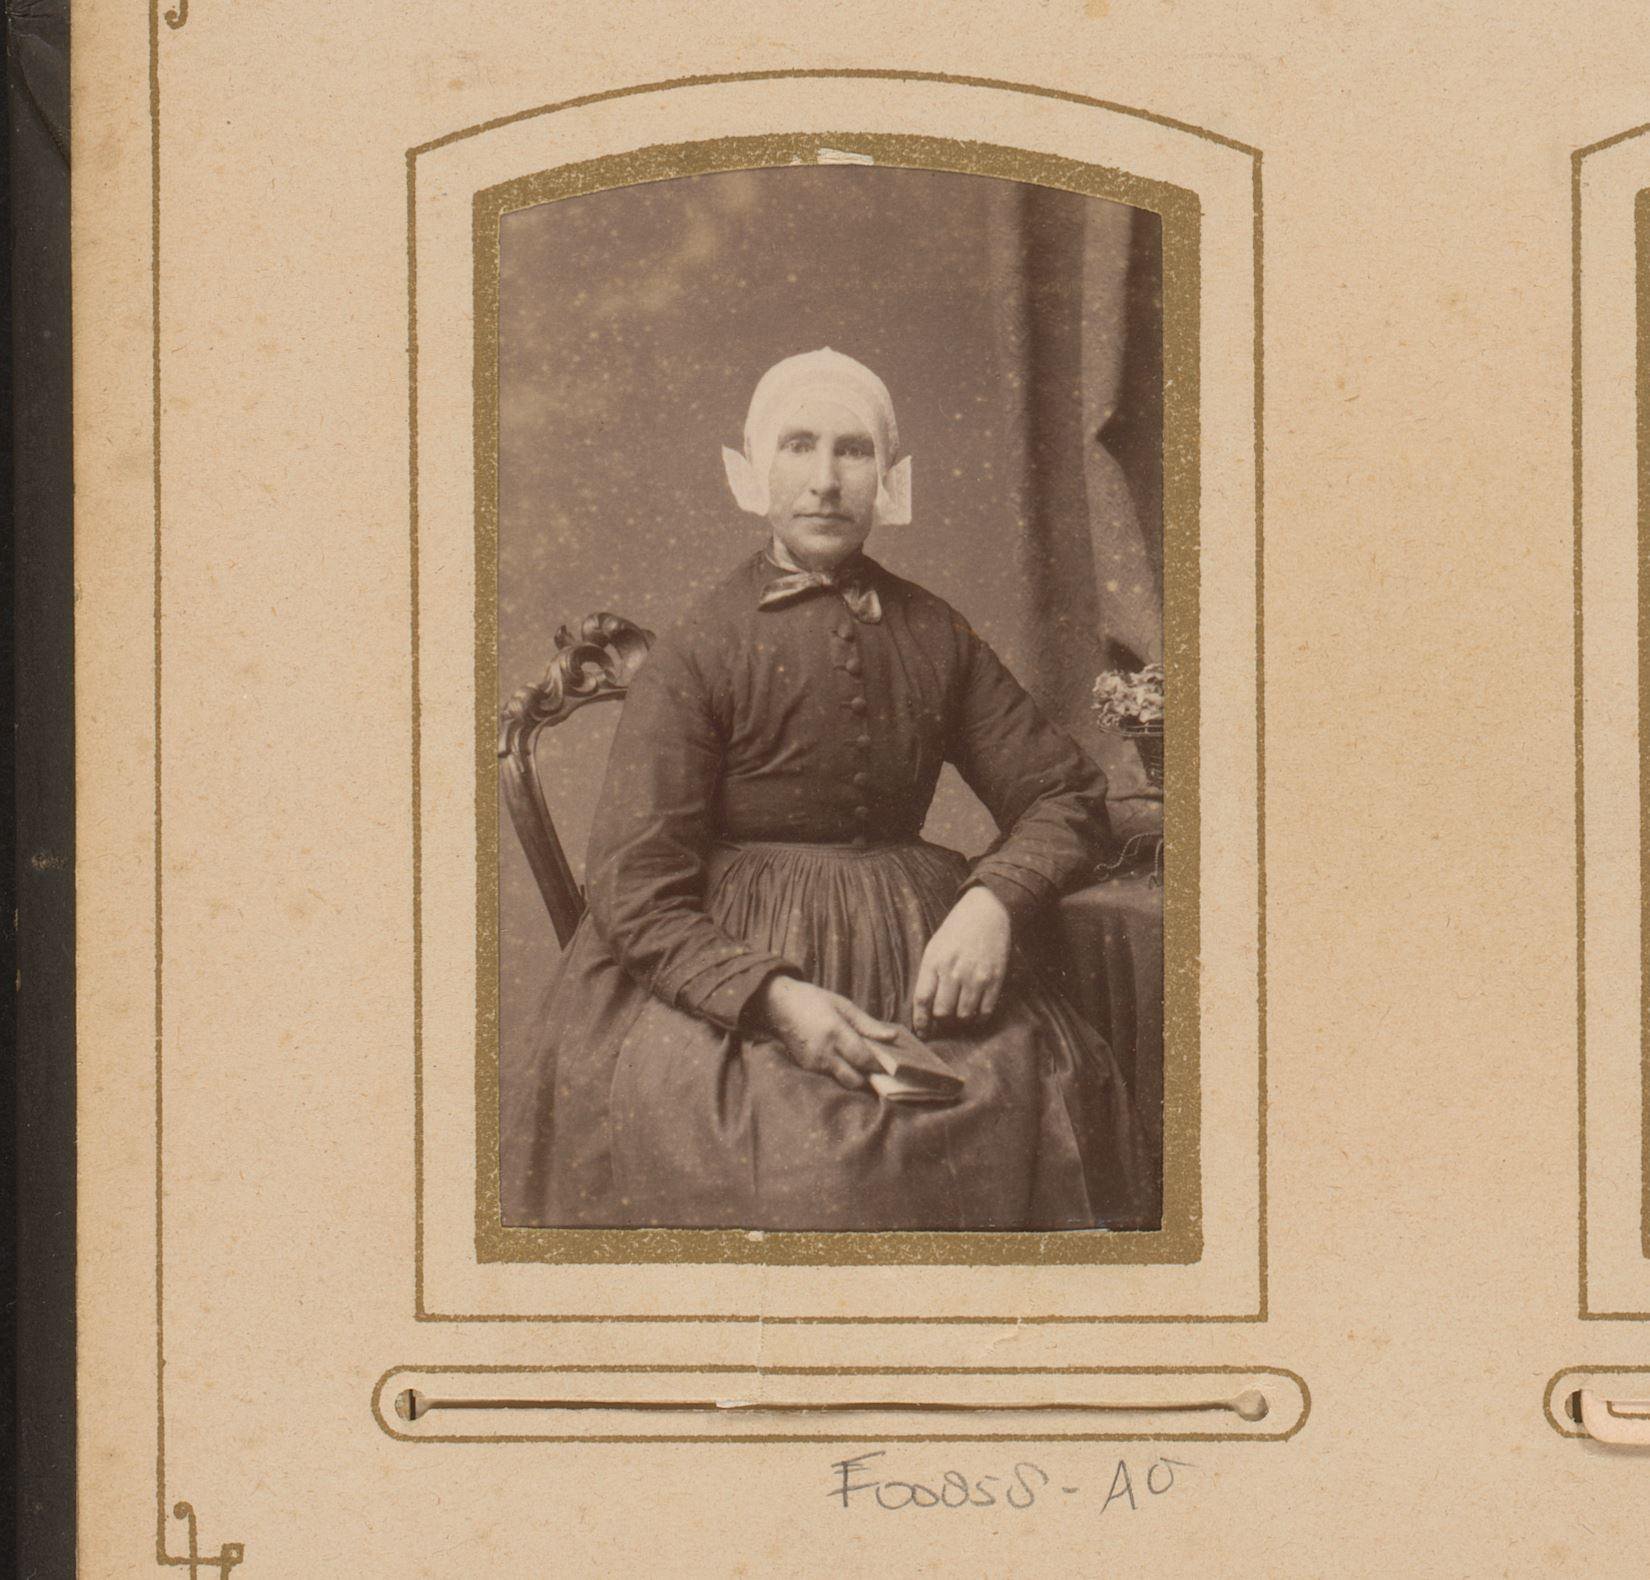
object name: carte de visite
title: Portret van een zittende vrouw met muts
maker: dirk niekerk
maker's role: fotograaf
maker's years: 1824-1881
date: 1879-1881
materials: cardboard, photographic support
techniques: albumen print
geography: amsterdam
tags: historical persons - bb - woman, head-gear: cap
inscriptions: inscription: ‘Amsterdam, Baangracht tusschen Leidsche Plein en Kruisstr. 248’